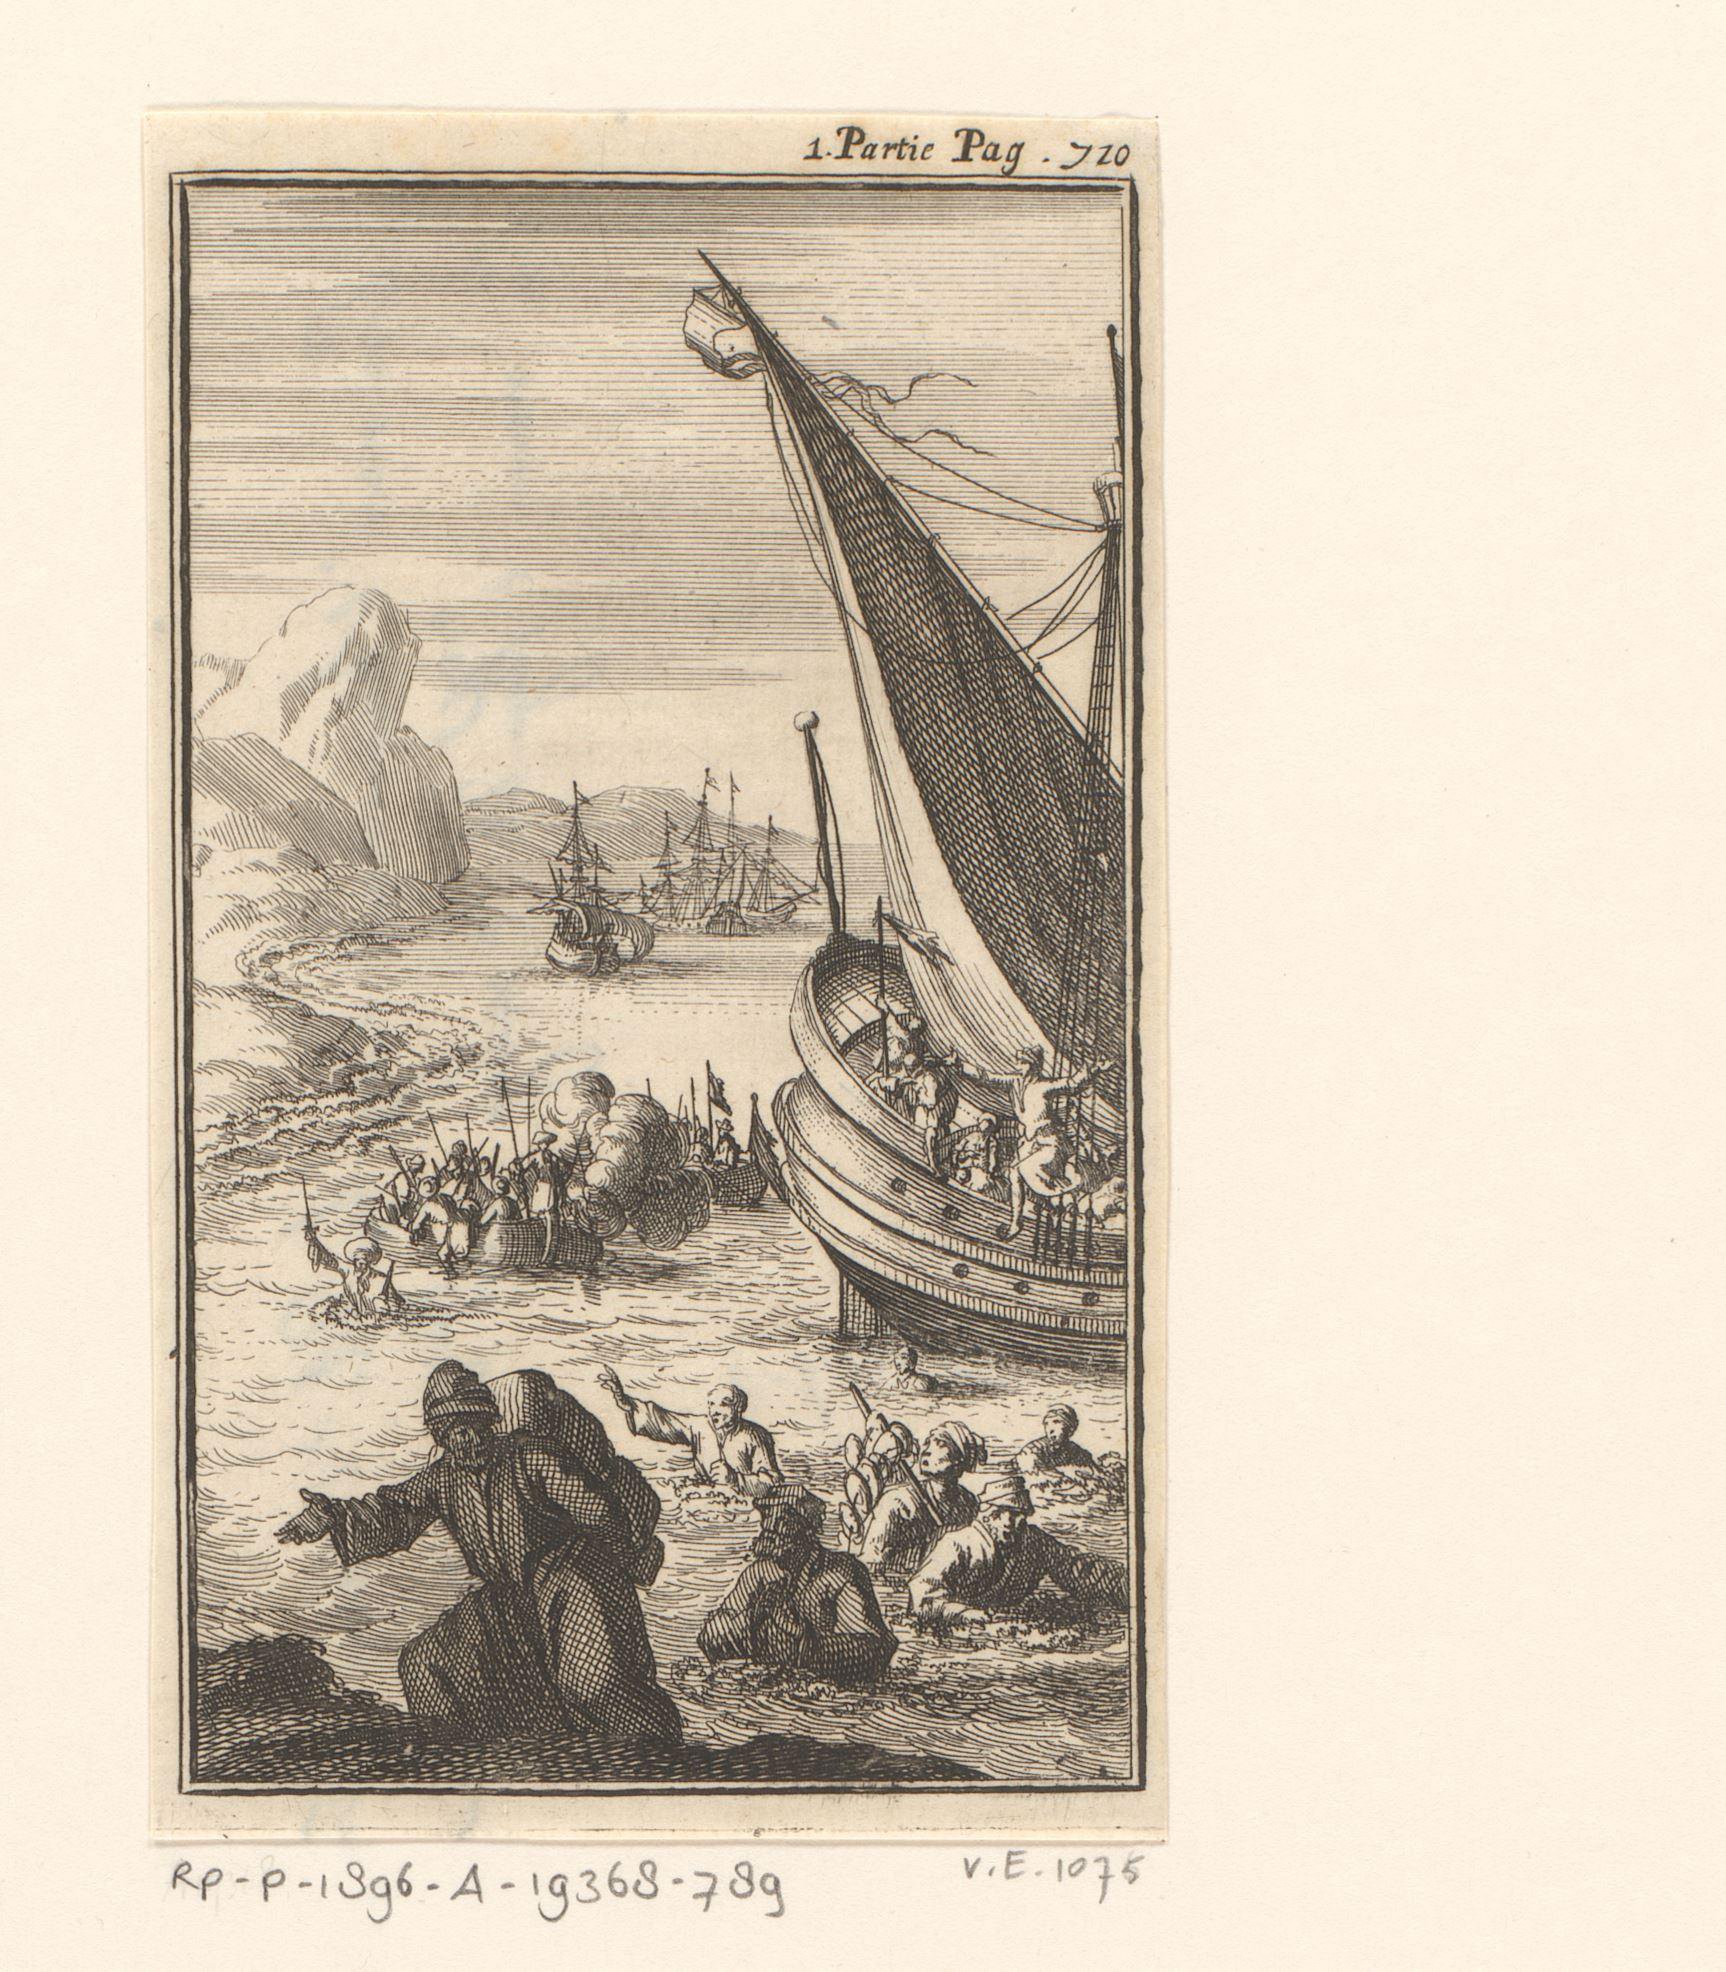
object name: book illustration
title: Schip van de schrijver Jean de Thevenot door zeerovers overmeesterd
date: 1689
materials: paper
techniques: etching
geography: amsterdam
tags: pirate, corsair, buccaneer, sailing-ship, sailing-boat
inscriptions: collector's mark: Lugt 2228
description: Illustratie uit: Thevenot, Jean de. Voyages Tant en Europe qu'en Asie et en Afrique, 4 delen. Parijs: Charles Angot, 1689, dl. II.